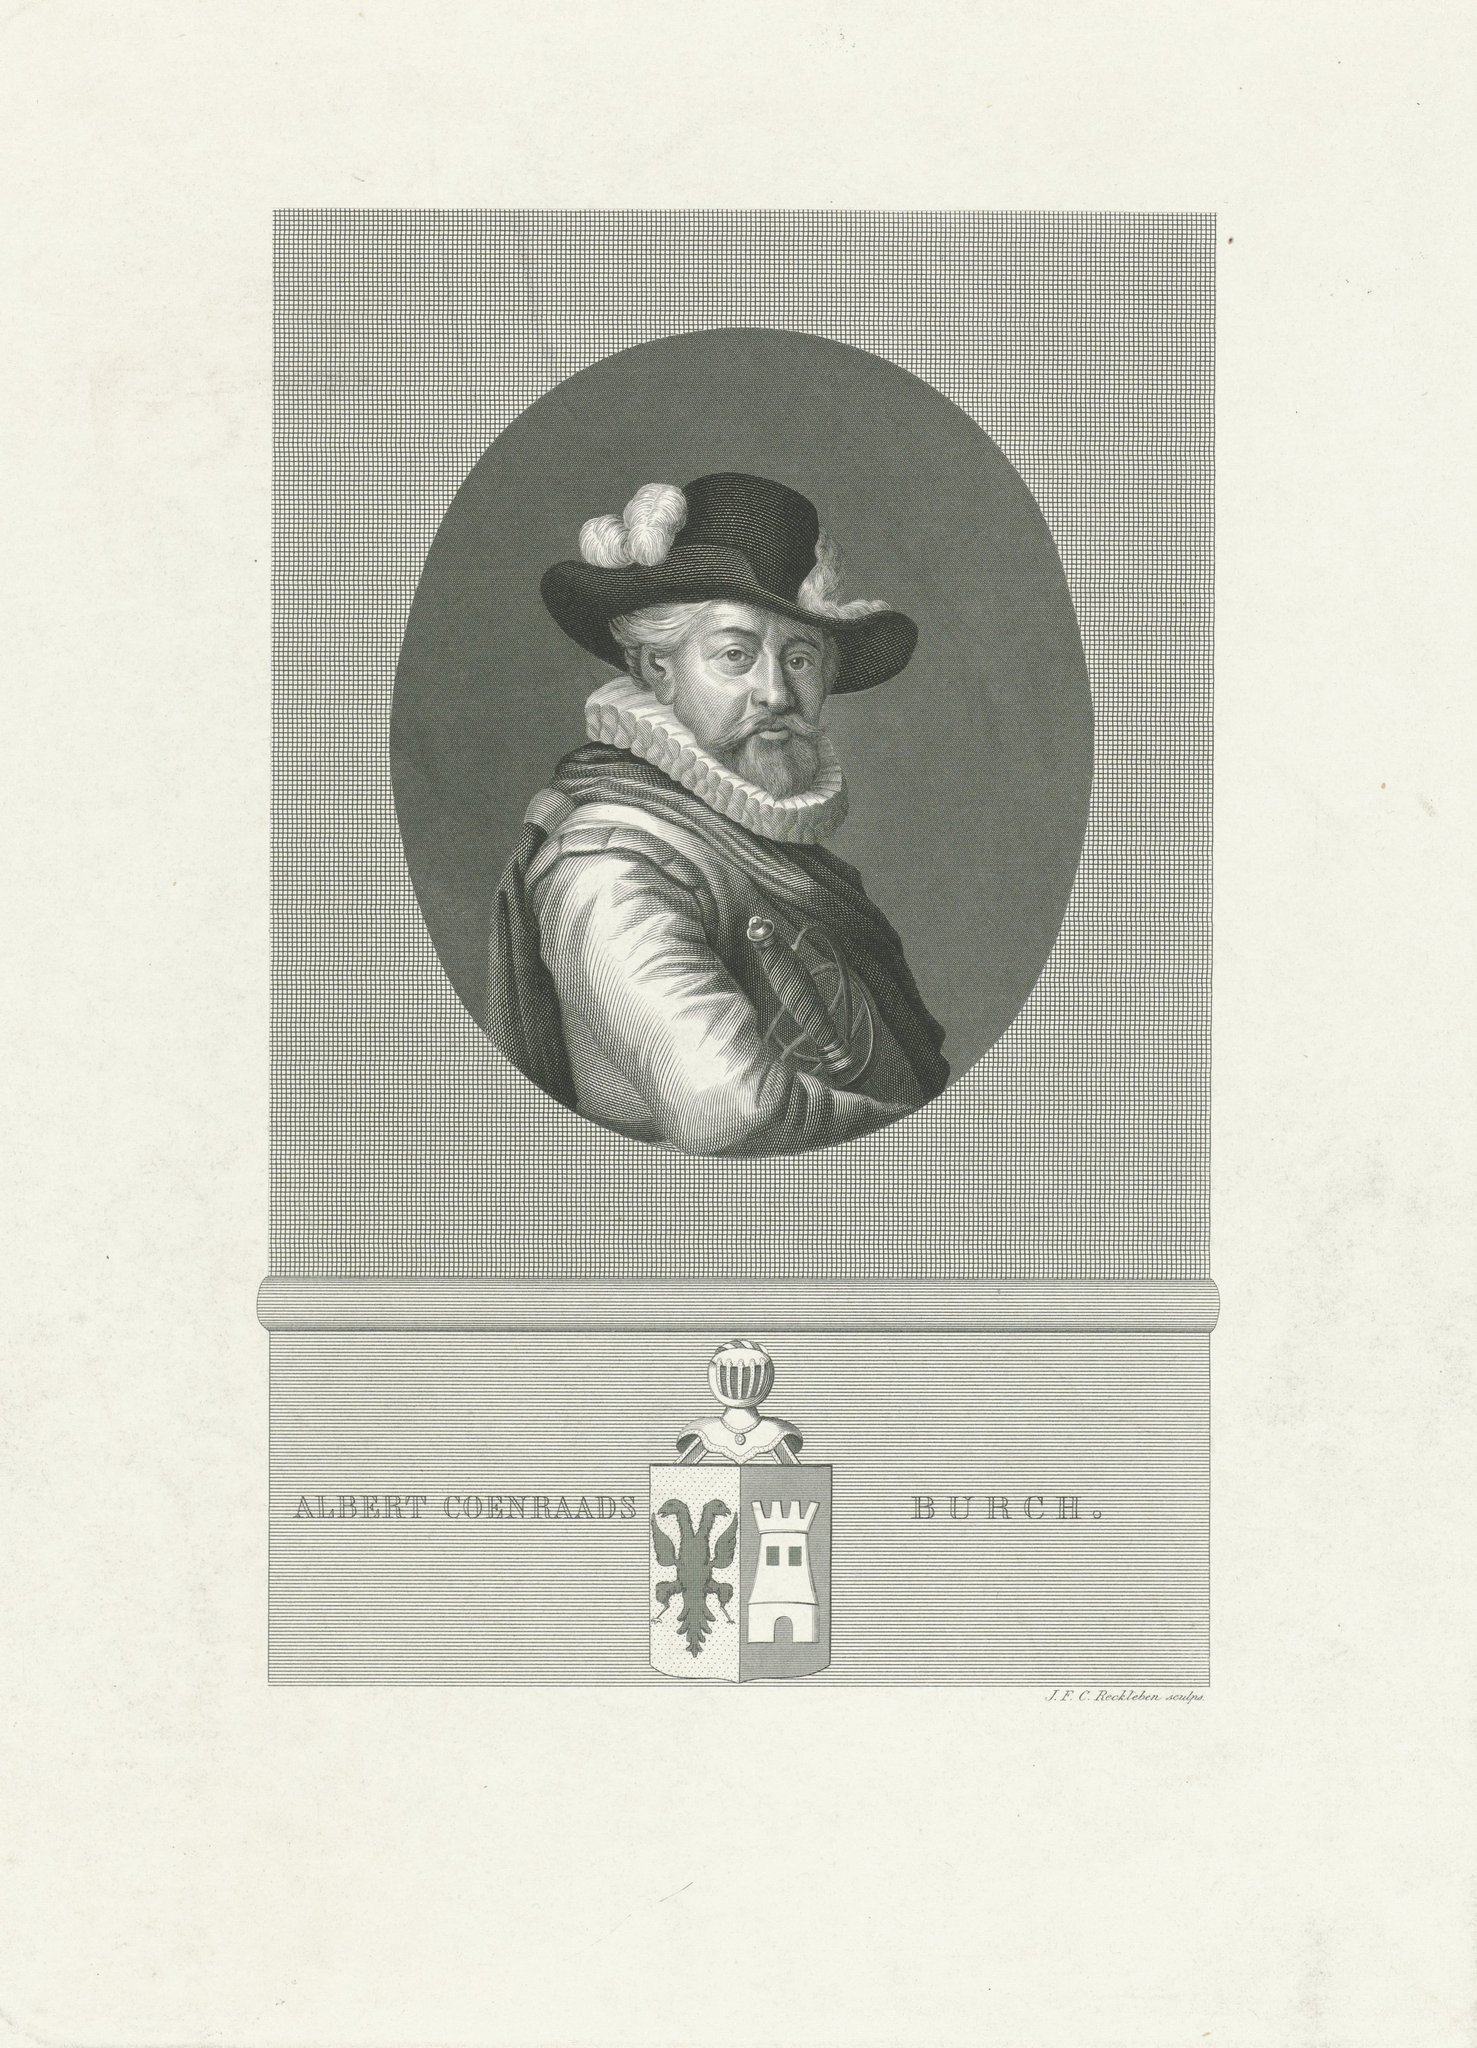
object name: print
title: Portret van Albert Coenraads Burgh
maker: jan frederik christiaan reckleben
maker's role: print maker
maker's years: 1819-1879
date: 1861-1863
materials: paper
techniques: engraving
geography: amsterdam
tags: albert coenraads burgh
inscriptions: collector's mark: Lugt 2228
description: Illustratie in: Arend, Johannes Pieter. Algemeene geschiedenis des vaderlands van de vroegste tijden tot op heden. 5 delen, Amsterdam: Schleijer, J.F. 1840-1884, dl. 3.4, p. 529.